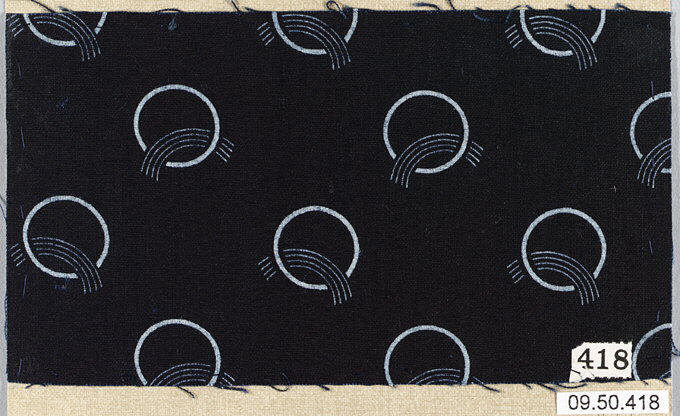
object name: piece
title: Piece (one of 116)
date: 1801-1900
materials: cotton